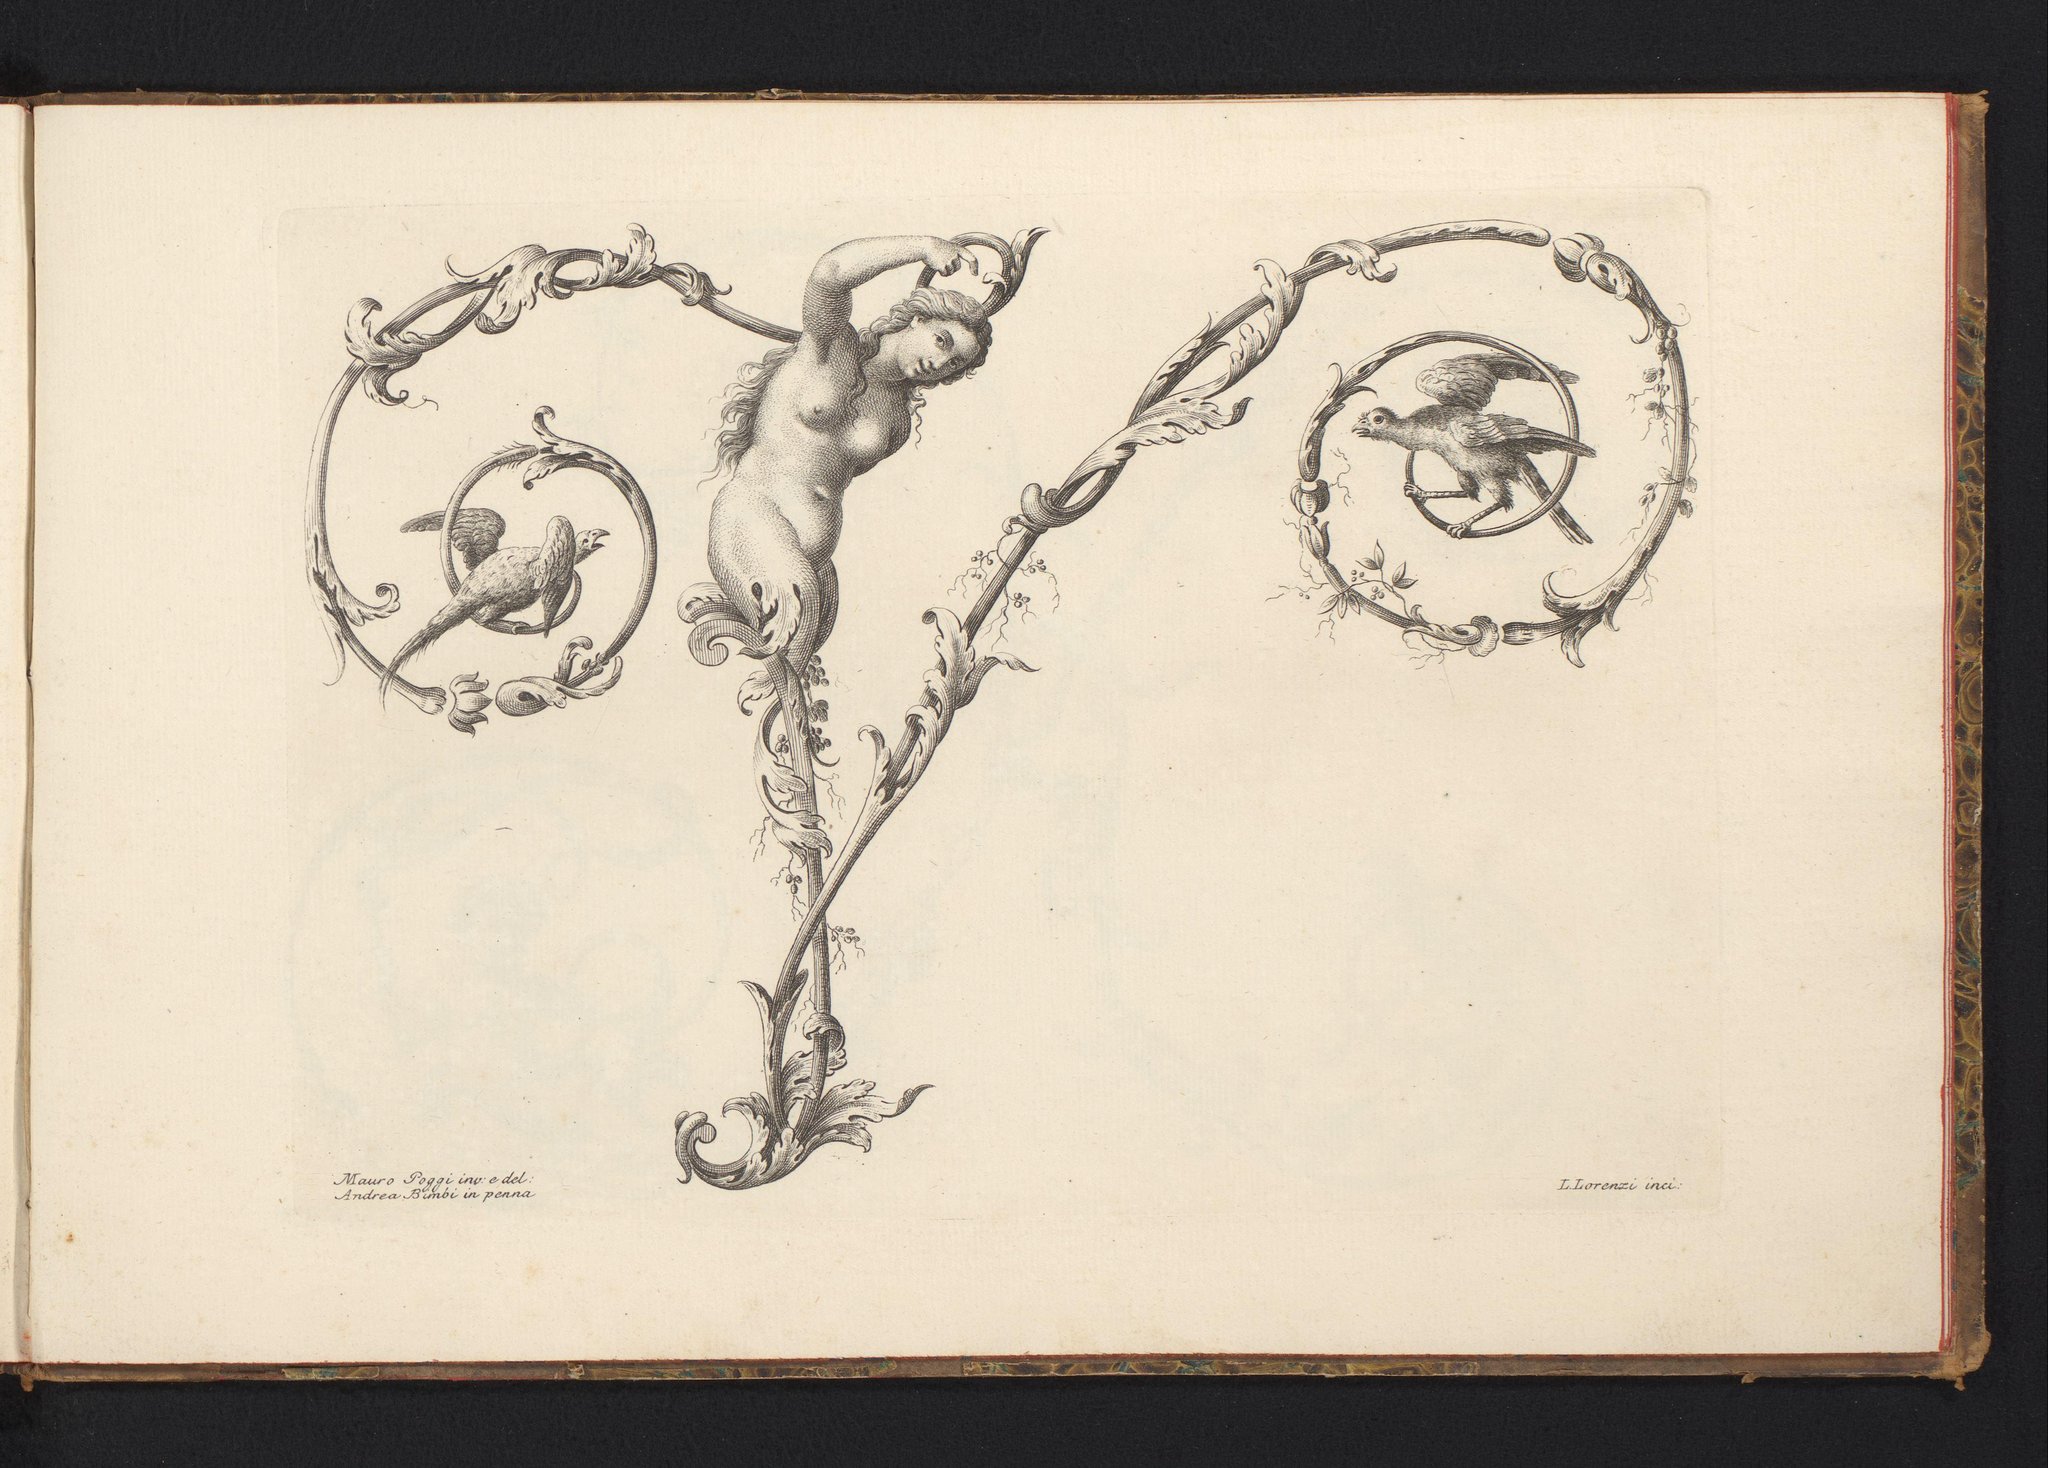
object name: album leaf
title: Ornamentele letter V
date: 1745-1765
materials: paper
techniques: engraving, etching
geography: italy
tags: letters, alphabet, script, fancy letters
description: Ornamentele letter V, versierd met twee vogels en een naakte vrouw die uitloopt in ornament. Prent maakt deel uit van een album.